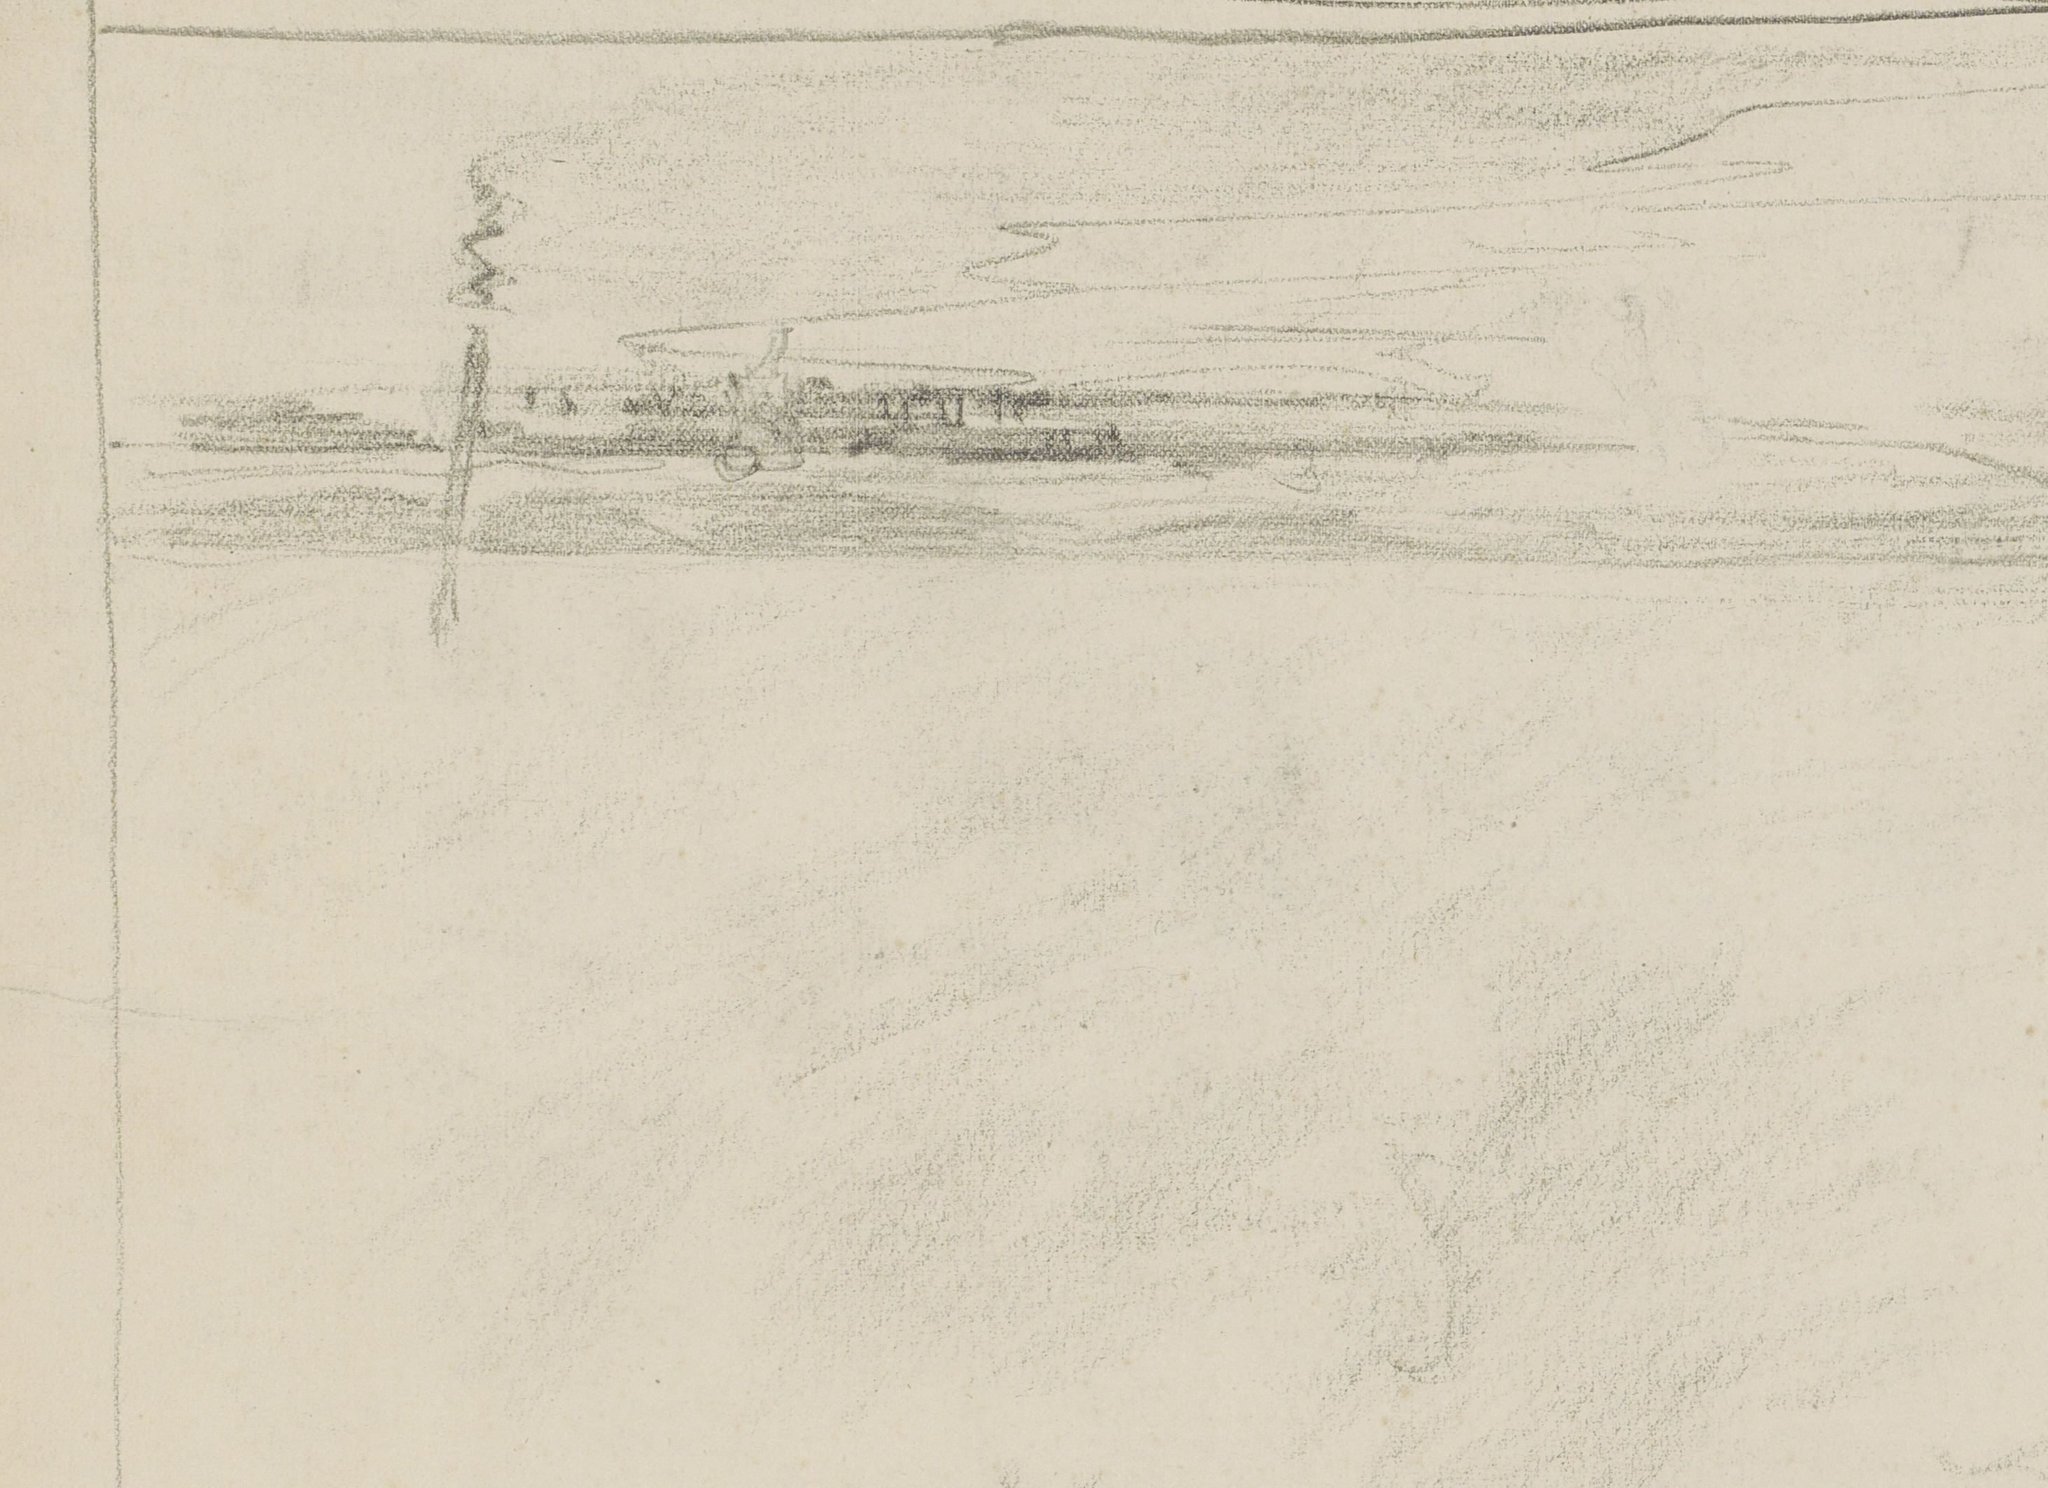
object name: sketchbook leaf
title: Zeegezicht met aanlegsteiger en een figuur aan de vloedlijn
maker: monogrammist ds (tekenaar)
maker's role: draughtsman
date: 1850-1950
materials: chalk, paper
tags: pier, quay, wharf, sea (seascape) (+ landscape with figures, staffage)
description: Blad 10 verso uit een schetsboek met 17 bladen.